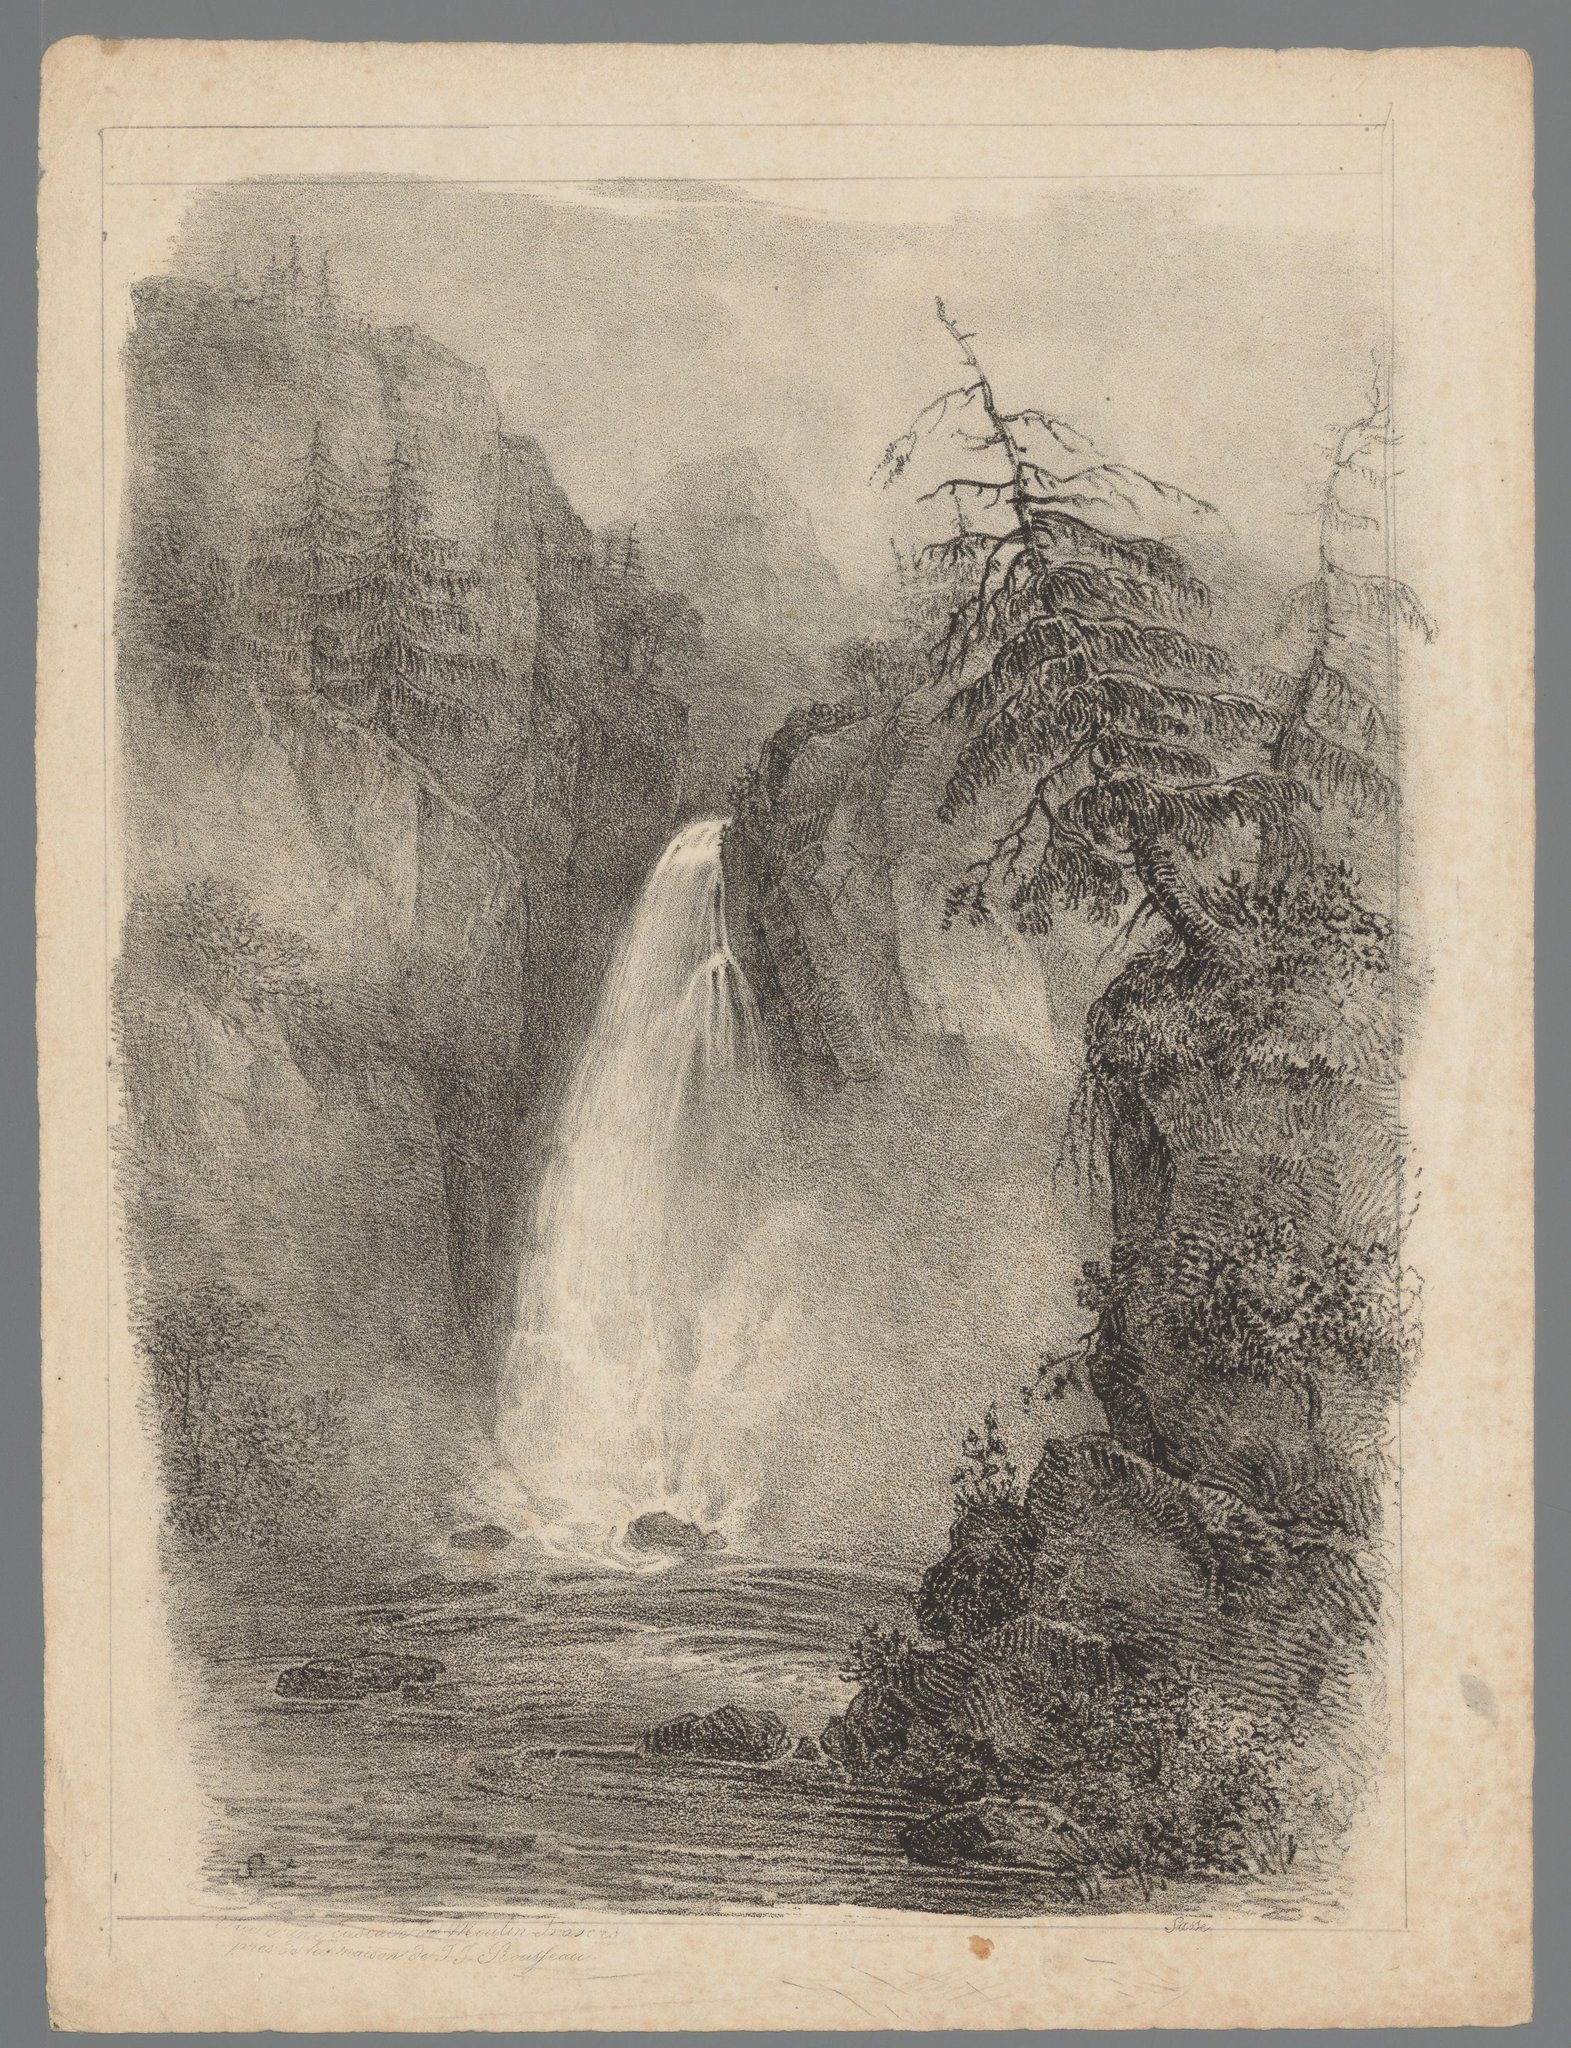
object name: print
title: L'art de dessiner le paysage d'apres nature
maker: richard sasse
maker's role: print maker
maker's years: 1774-1849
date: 1800-1849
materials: paper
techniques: lithograph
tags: waterfall, france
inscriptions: collector's mark: Lugt 2228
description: Prent behoort tot de serie 'L'art de dessiner le paysage d'apres nature'. Deze serie is in tien delen met elk zes lithografieën uitgegeven.